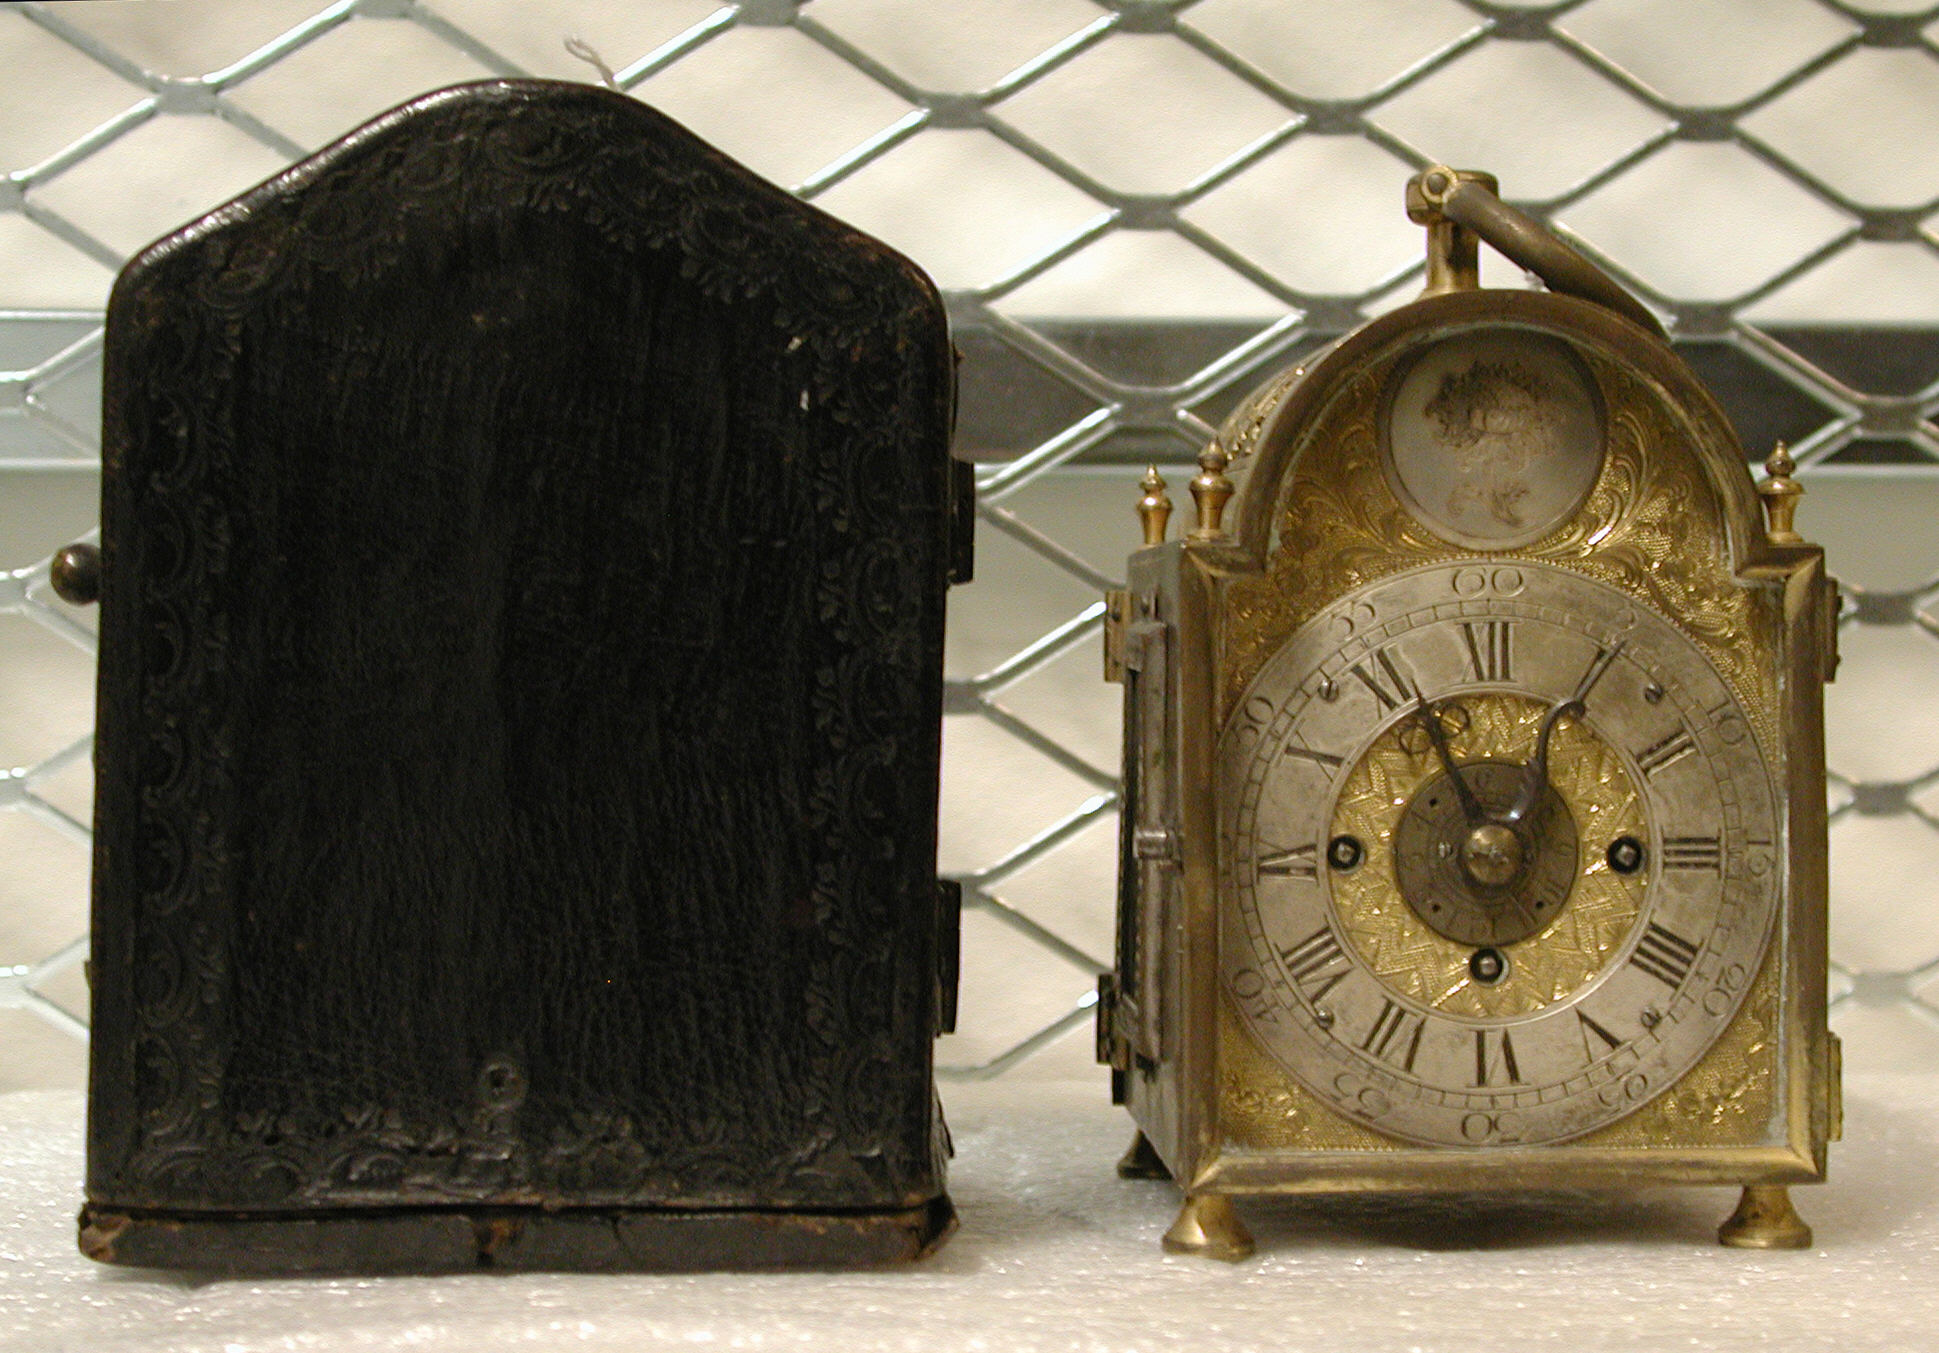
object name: traveling clock and case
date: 1701-1733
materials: brass, glass, leather, silver